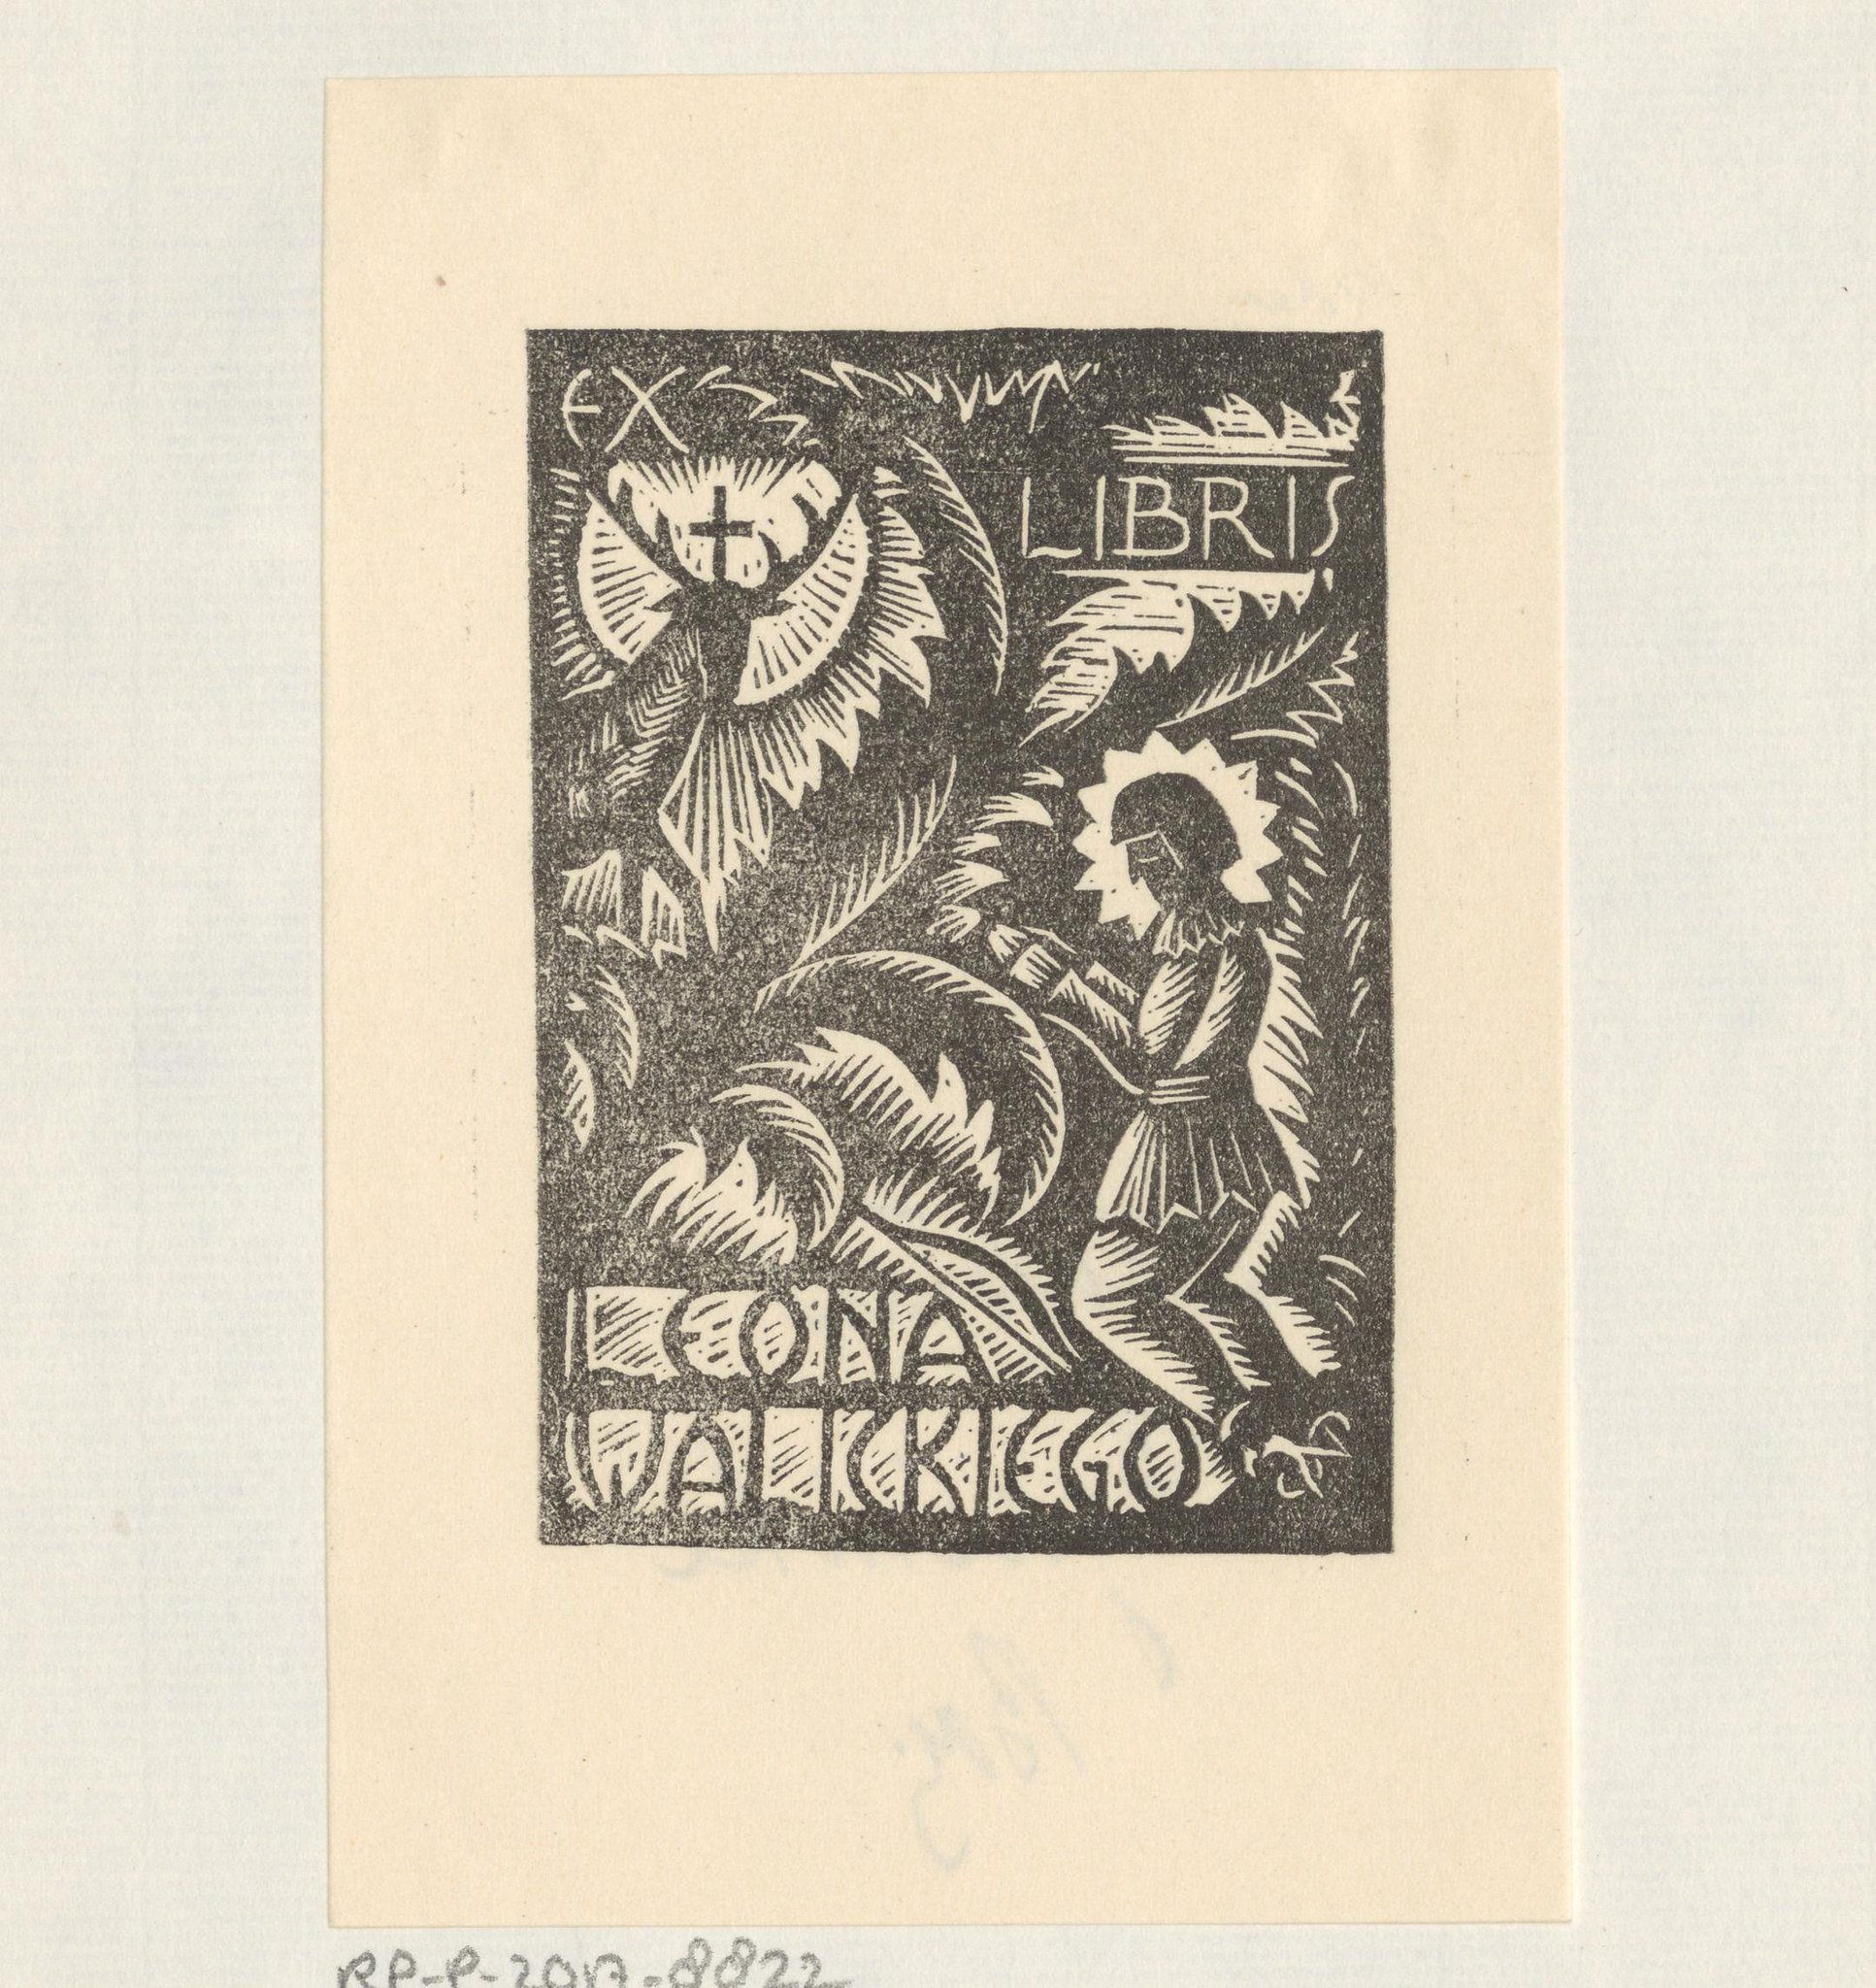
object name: bookplate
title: Ex libris Leona Walickiego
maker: stanisław zgaiński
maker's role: print maker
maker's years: 1907-1944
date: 1917-1944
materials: paper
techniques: woodcut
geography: czech republic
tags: hoofed animals: stag, the hunter hubert(us), bishop of maastricht and liège; possible attributes: hounds, hunting horn, key, stag with crucifix, (bishop's) stole, one person praying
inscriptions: inscription: ‘Stanislav/ Zgainski/ B[...]’